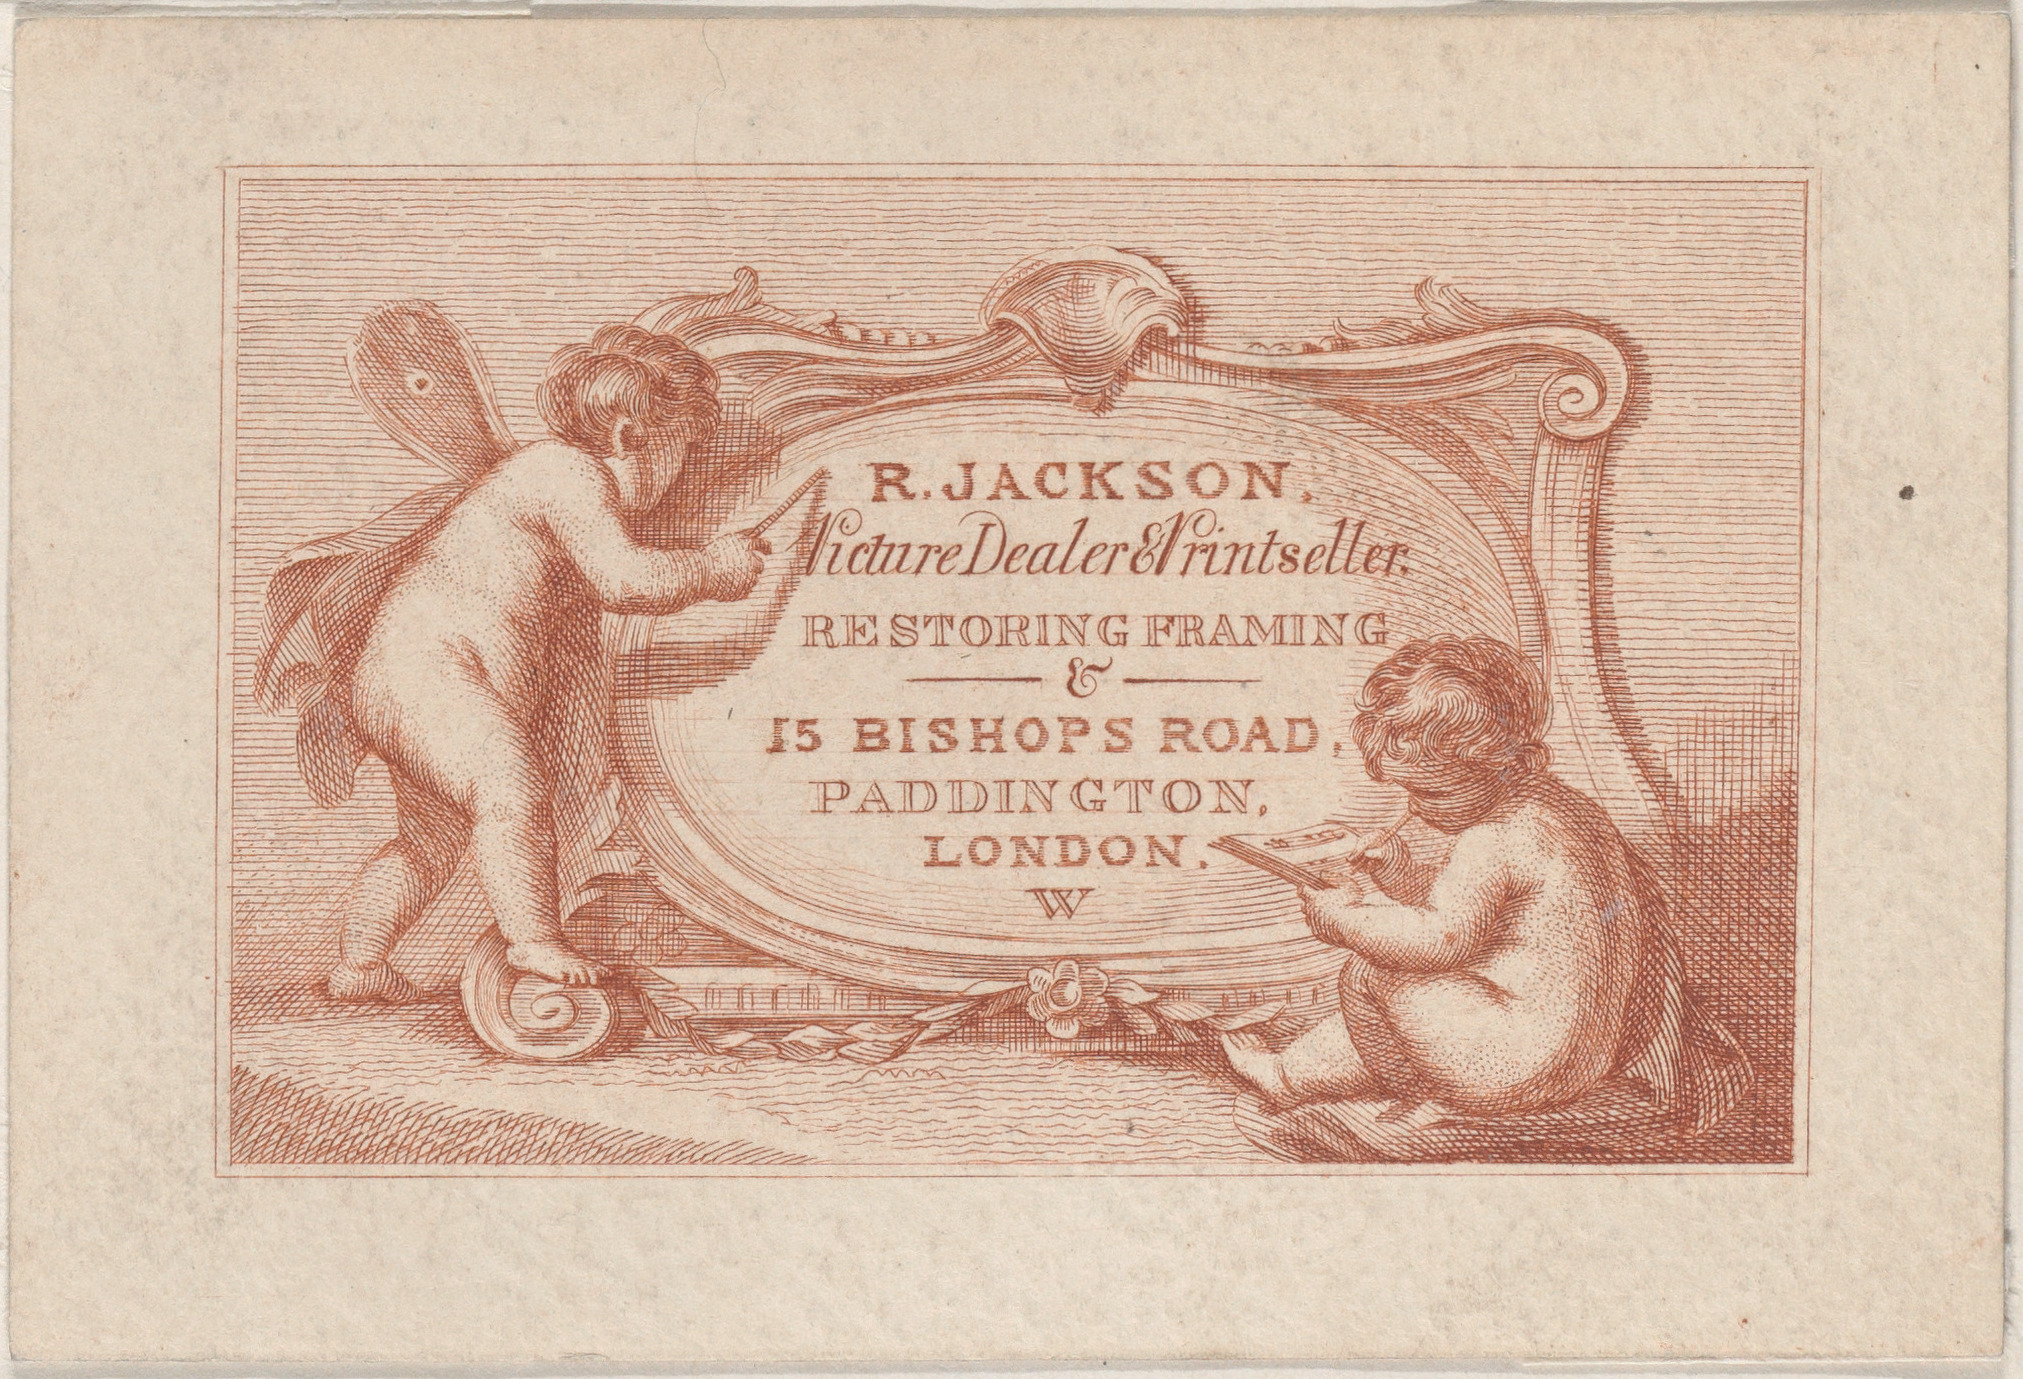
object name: print, trade card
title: Trade Card for Robert Jackson, Picture Dealer, Printseller, and Restorer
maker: anonymous, british, 19th century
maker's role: artist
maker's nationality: british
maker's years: 1800-1900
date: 1801-1900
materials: ink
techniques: engraving